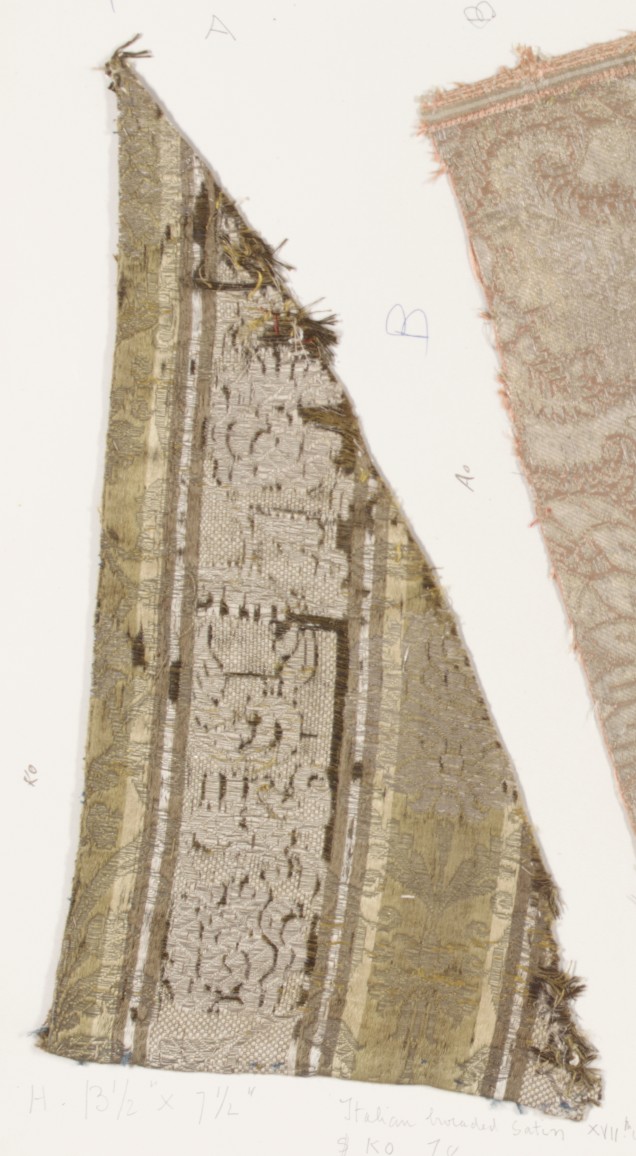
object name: fragment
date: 1601-1700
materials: metal thread, silk